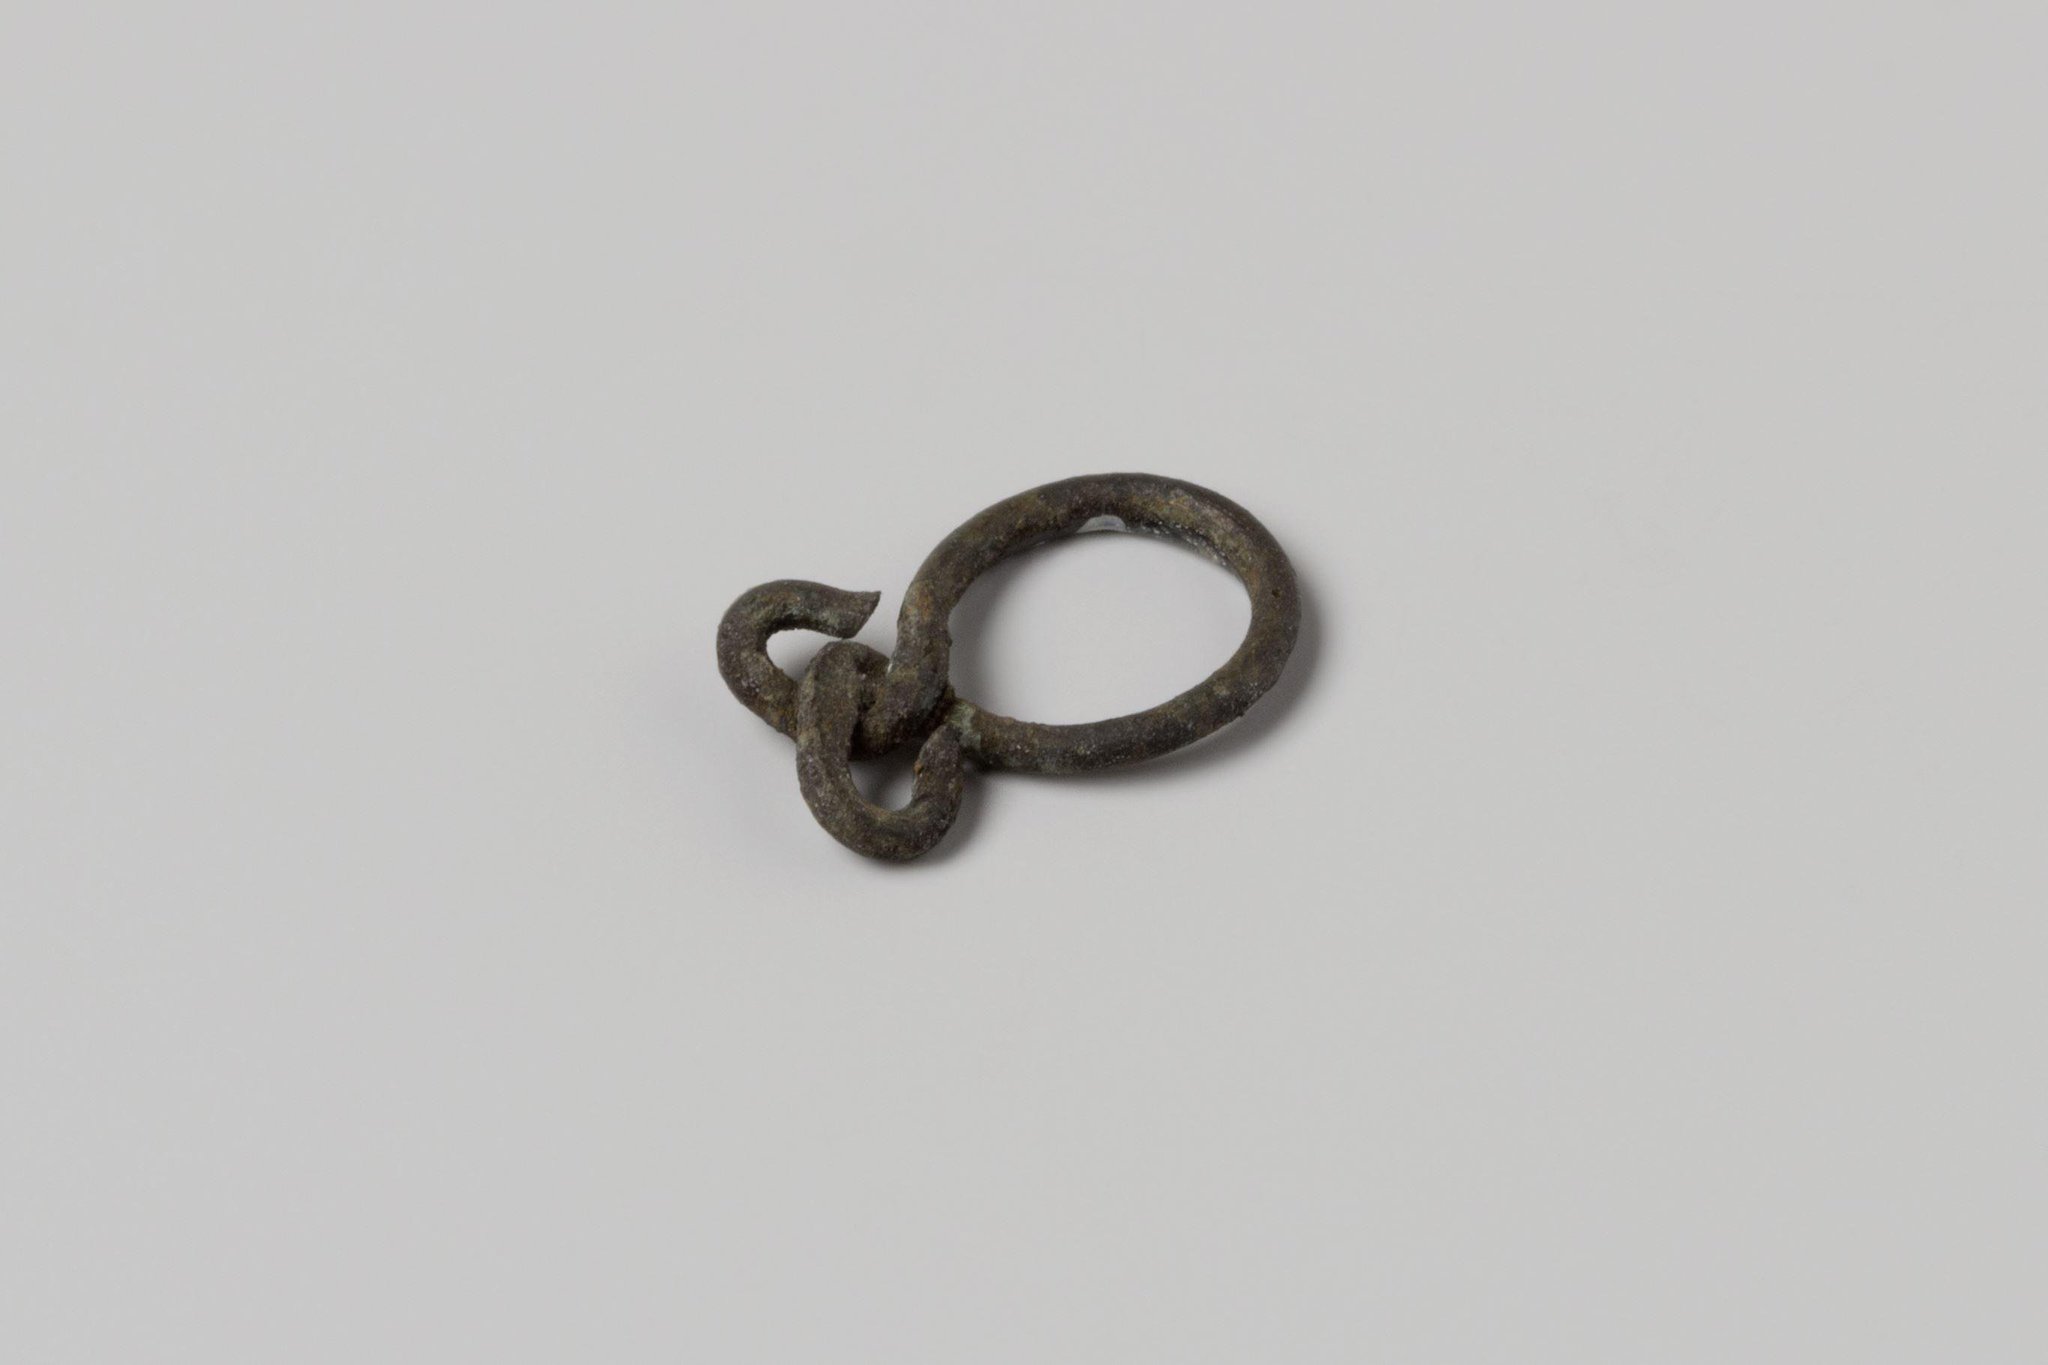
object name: hook and eye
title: Oogje uit het wrak van de Oost-Indiëvaarder Hollandia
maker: Anonymous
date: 1700-1743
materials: copper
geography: netherlands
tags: verenigde oostindische compagnie, hollandia (schip), annet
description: Oogje. Eye; (1) circular looped wire (0.1d), looped ends fitted together.